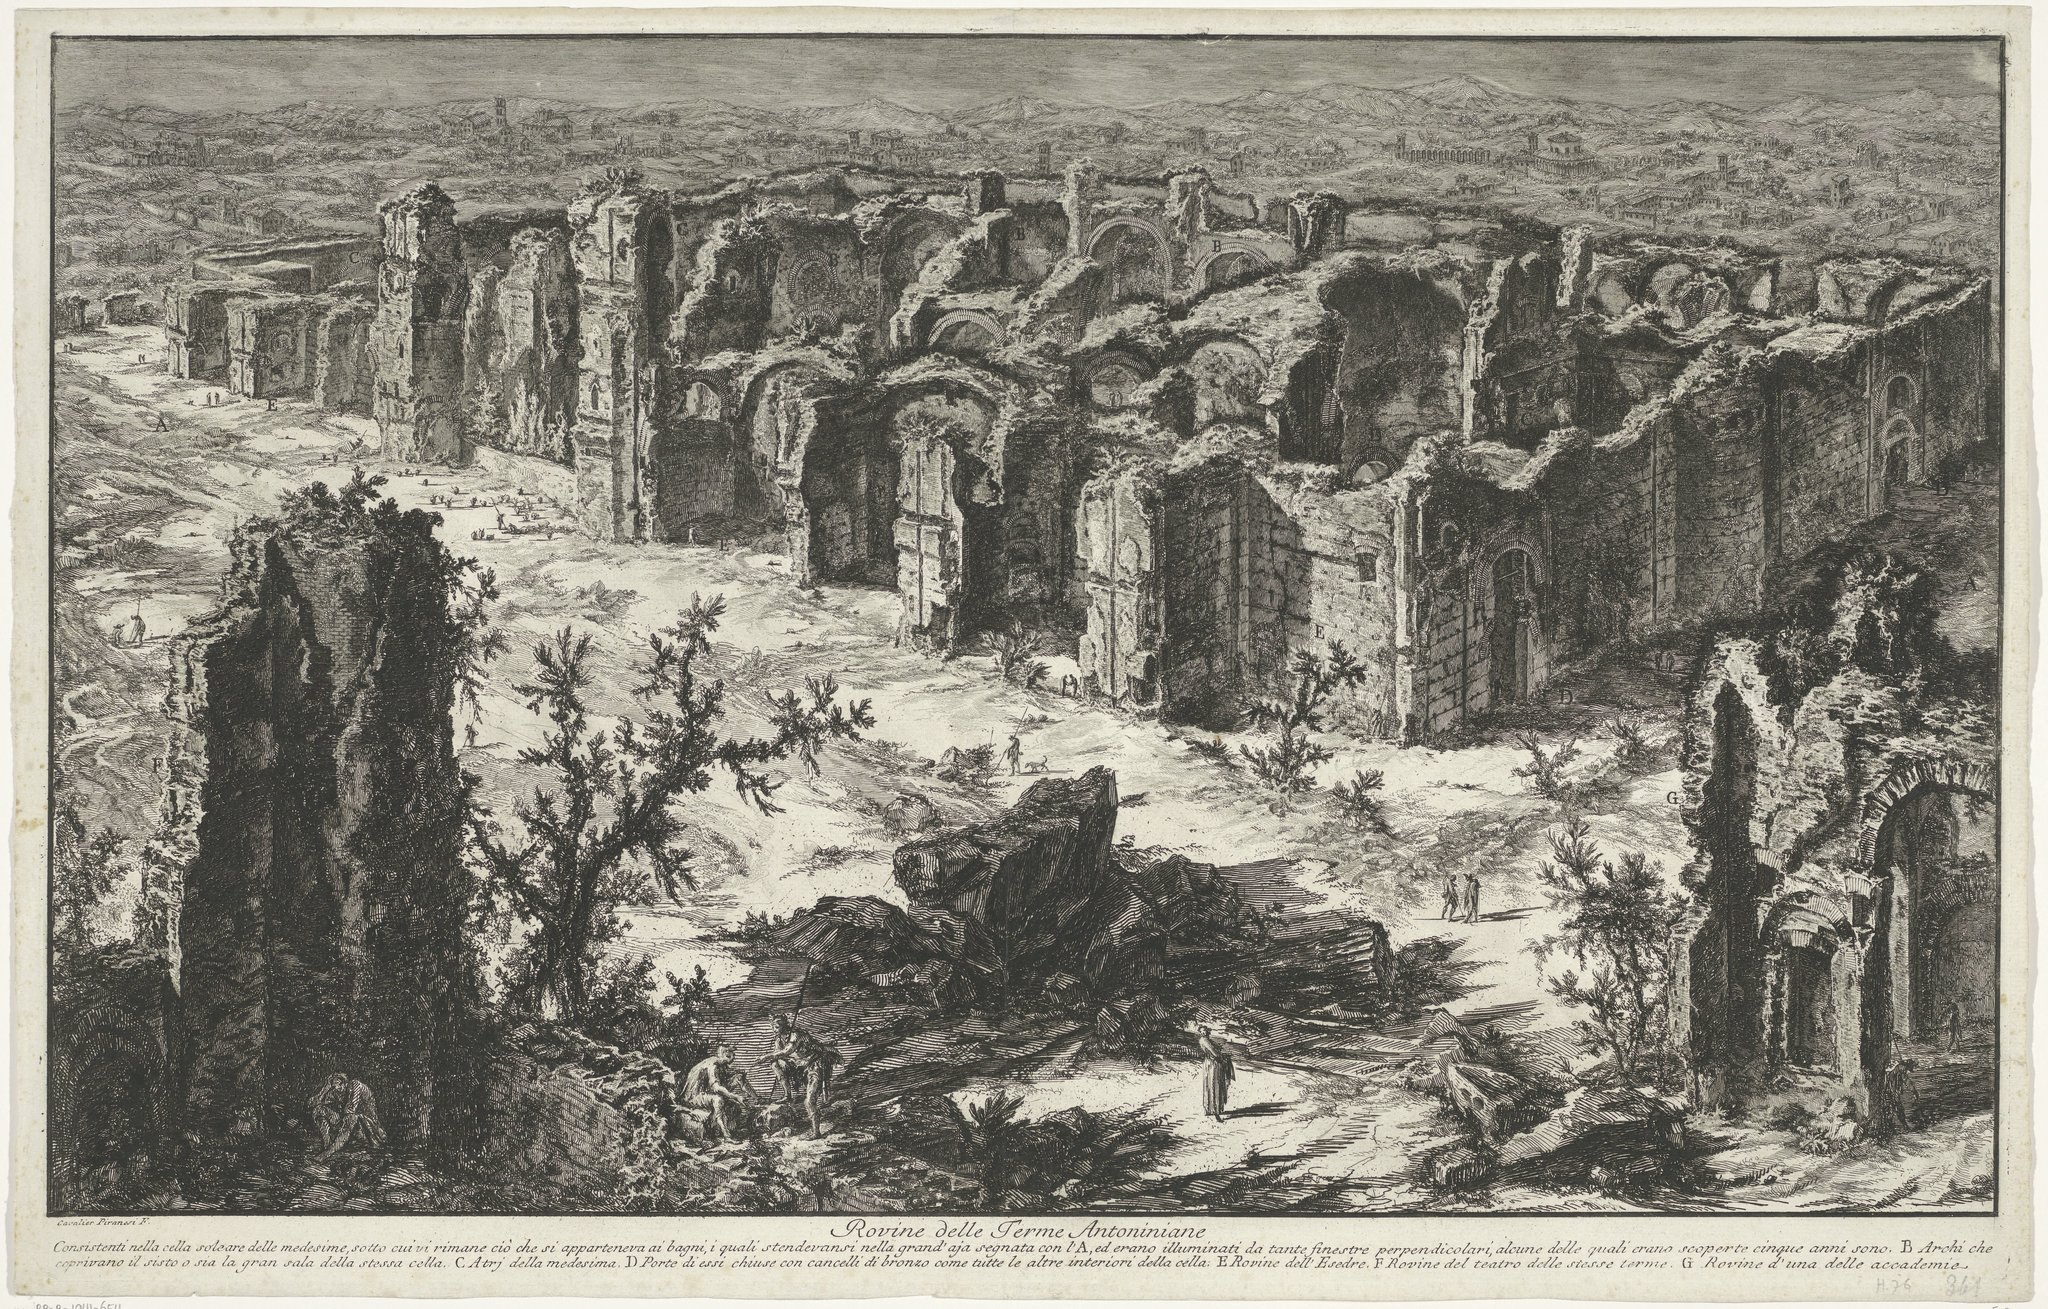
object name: print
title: Thermen van Caracalla te Rome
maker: giovanni battista piranesi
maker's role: designer, draughtsman, print maker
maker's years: 1720-1778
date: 1748-1778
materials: paper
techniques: etching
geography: rome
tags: city-view, and landscape with man-made constructions, ruin of a building ~ architecture, landscape with ruins, public baths, rome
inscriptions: collector's mark: Lugt 2228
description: Deze prent maakt deel uit van de serie 'Vedute di Roma'. Piranesi werkte aan deze 135 platen tellende serie tussen 1748 en zijn dood in 1778. Francesco Piranesi voegde later nog twee prenten toe aan de reeks van zijn vader.